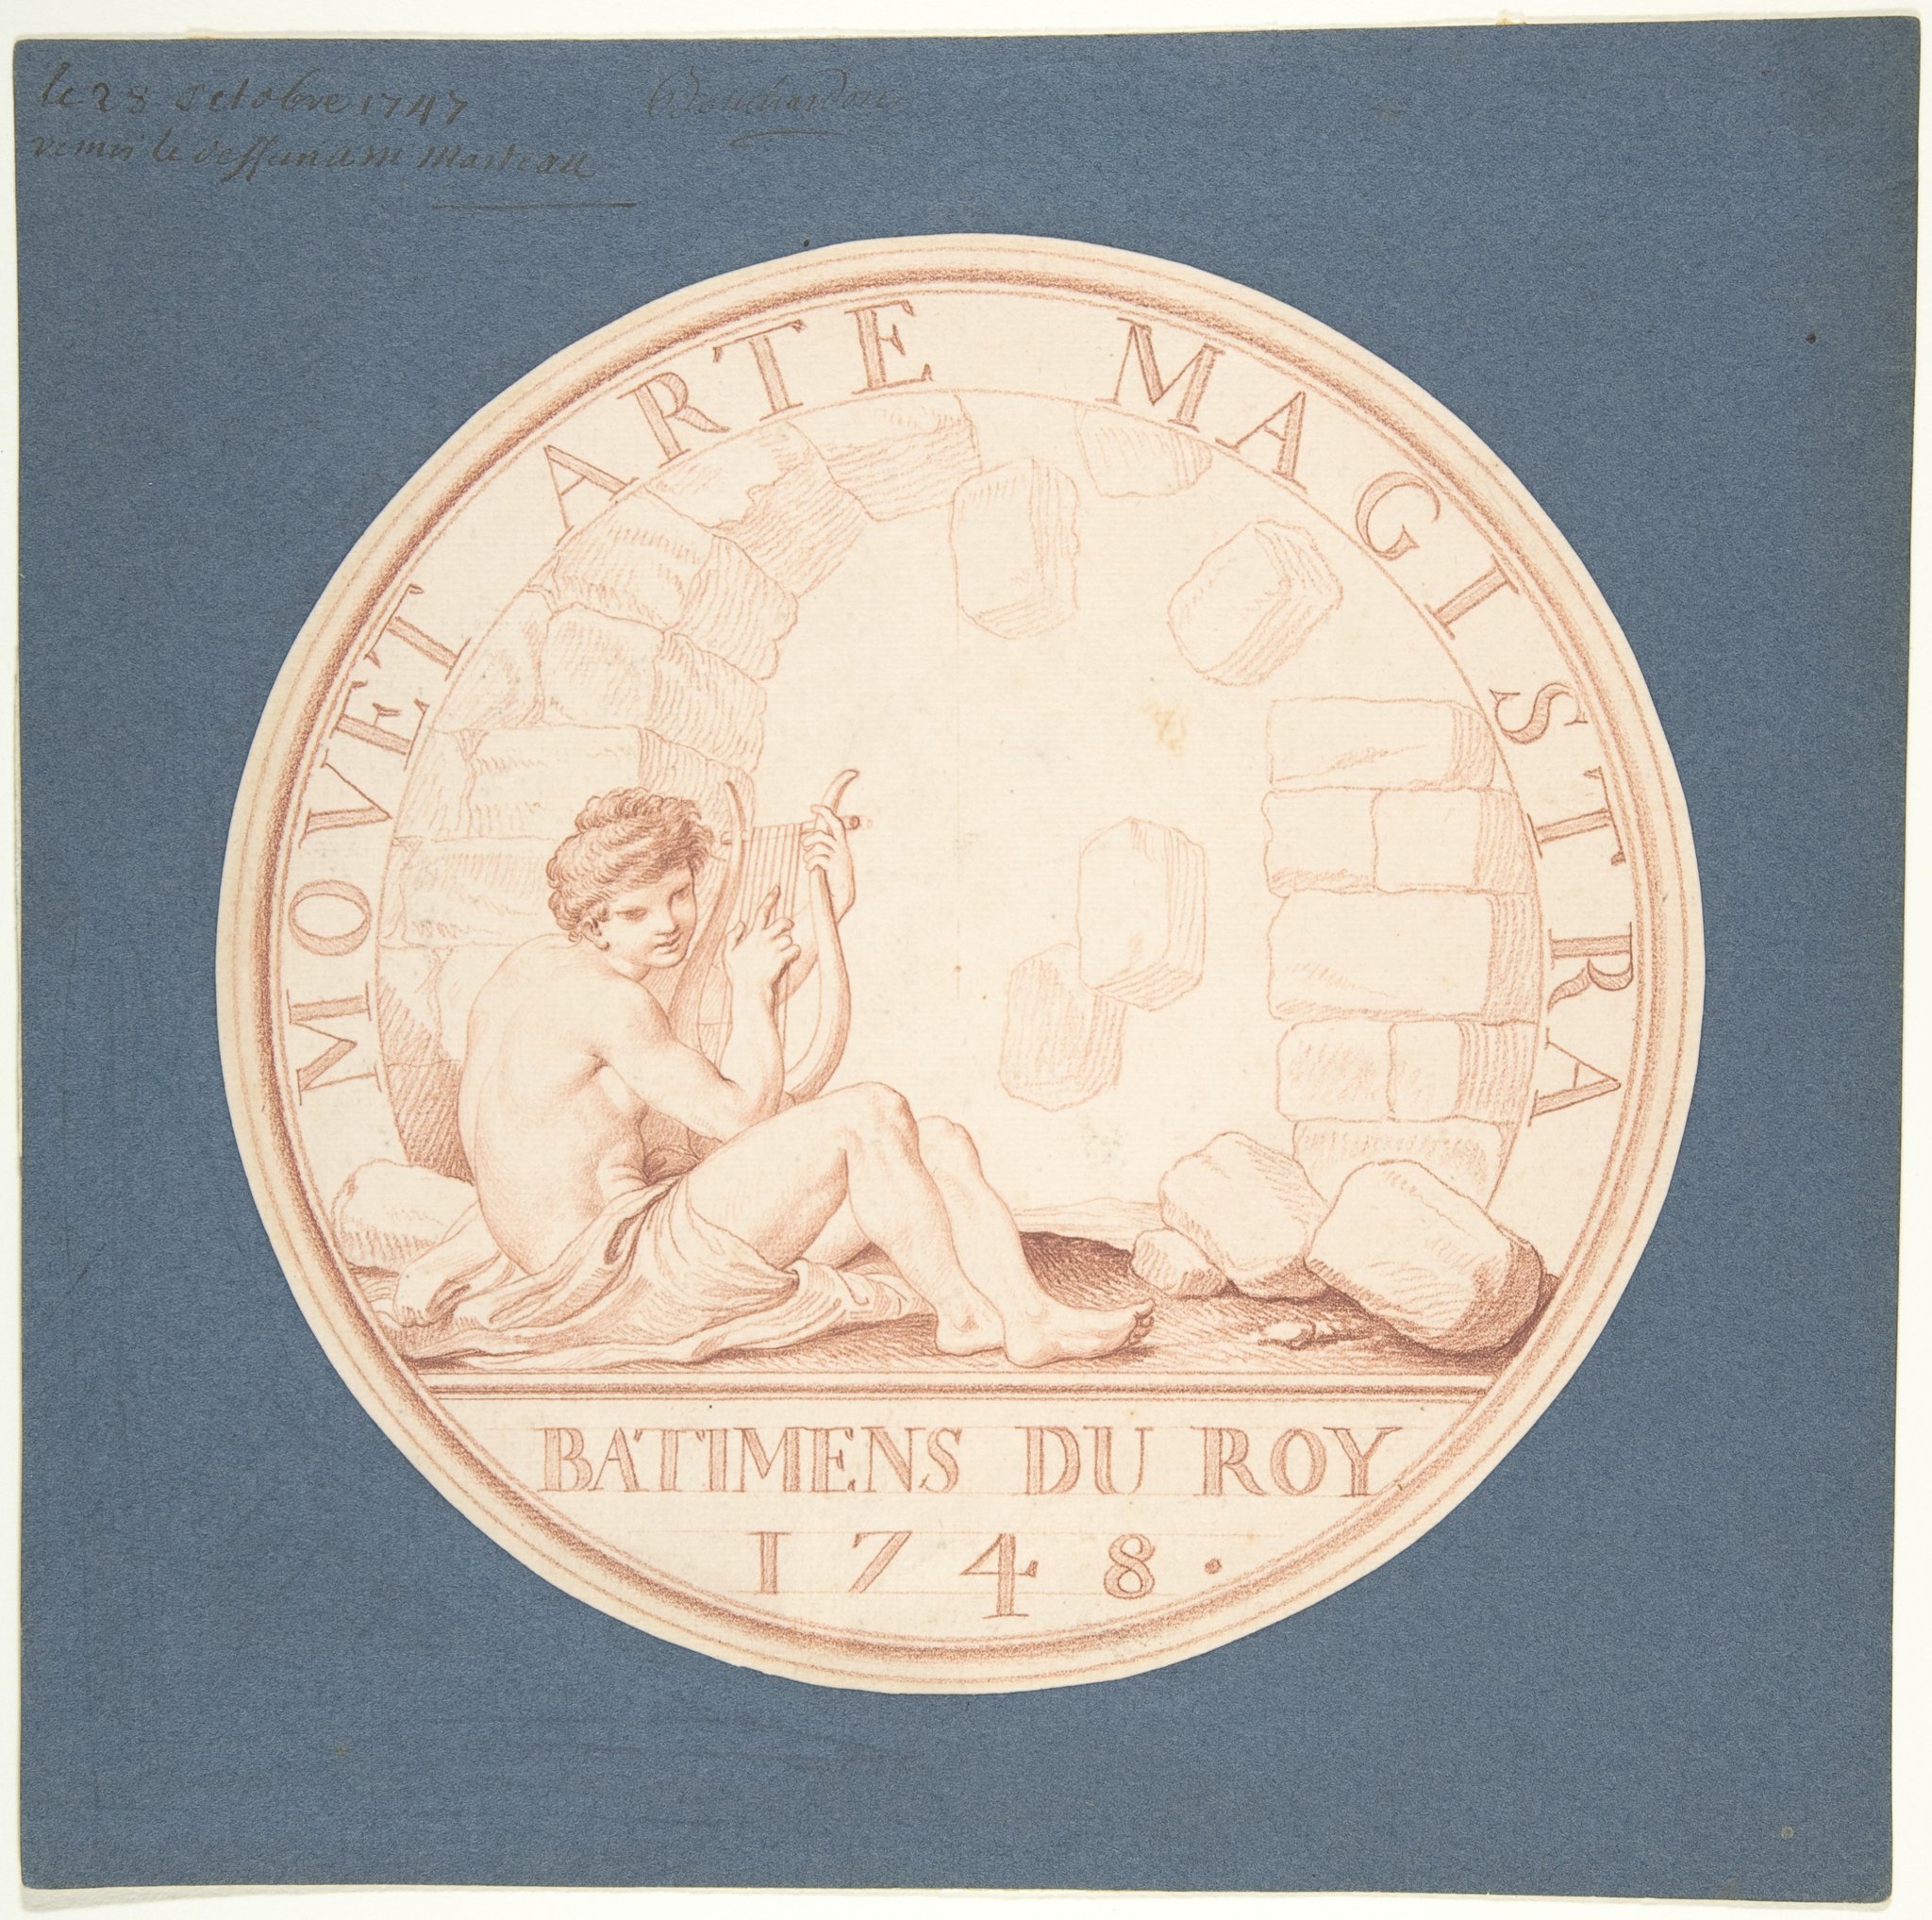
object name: drawing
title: Design for a Token: Bâtiments du Roi, 1748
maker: edme bouchardon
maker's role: artist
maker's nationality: french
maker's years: 1698-1762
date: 1748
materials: chalk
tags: men,harps